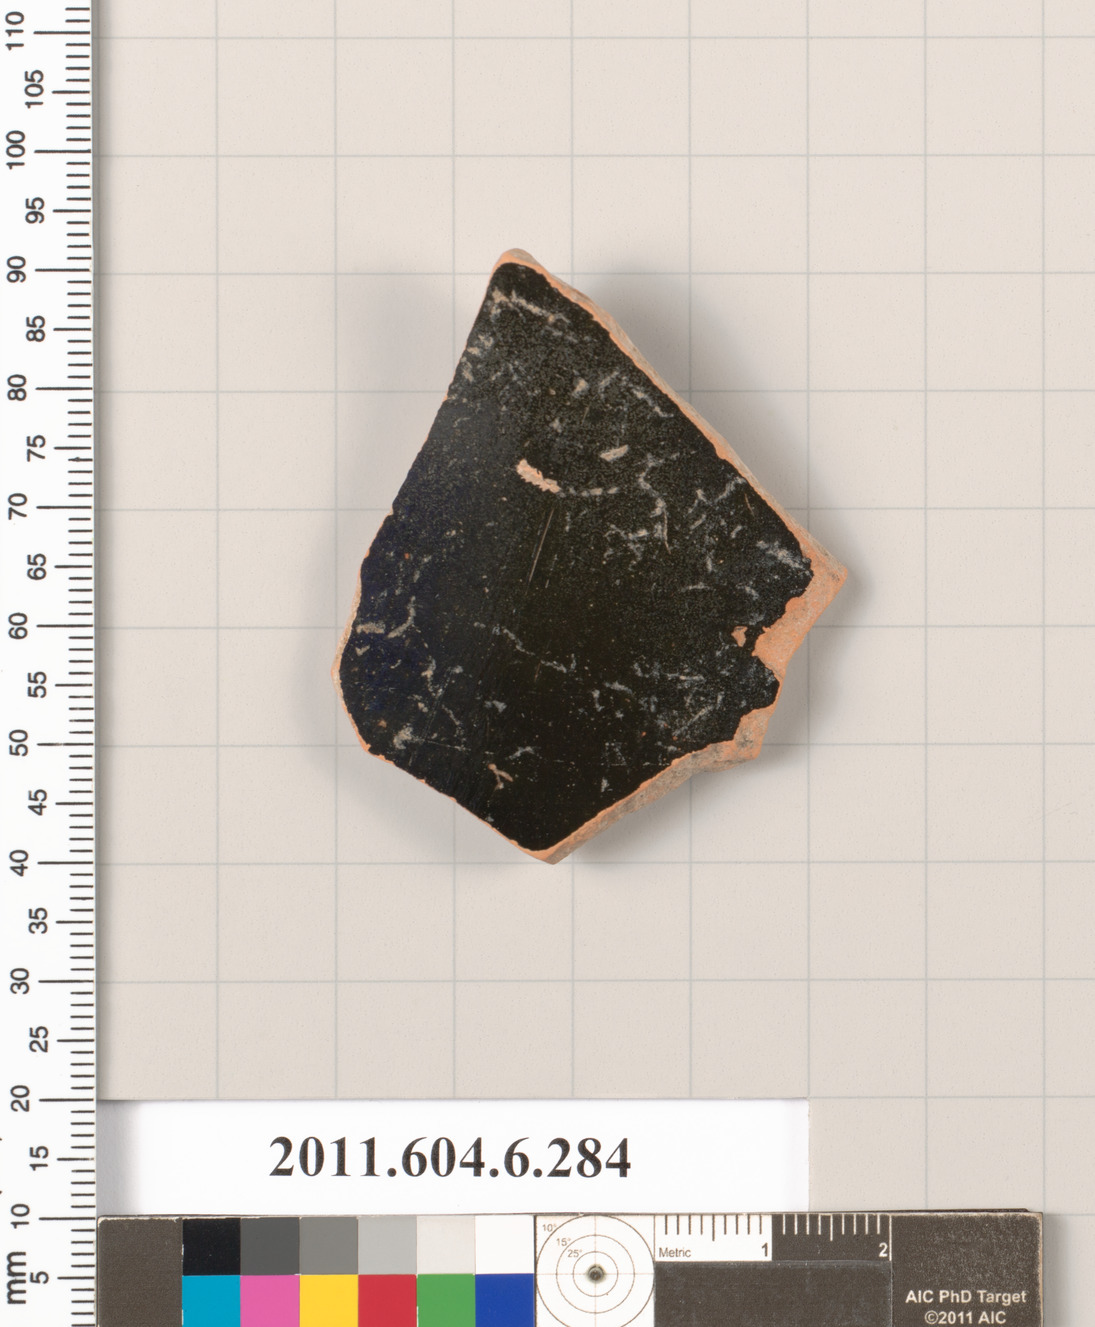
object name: oinochoe fragment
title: Terracotta fragment of an oinochoe (jug)?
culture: greek, attic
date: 500-401 BCE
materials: terracotta